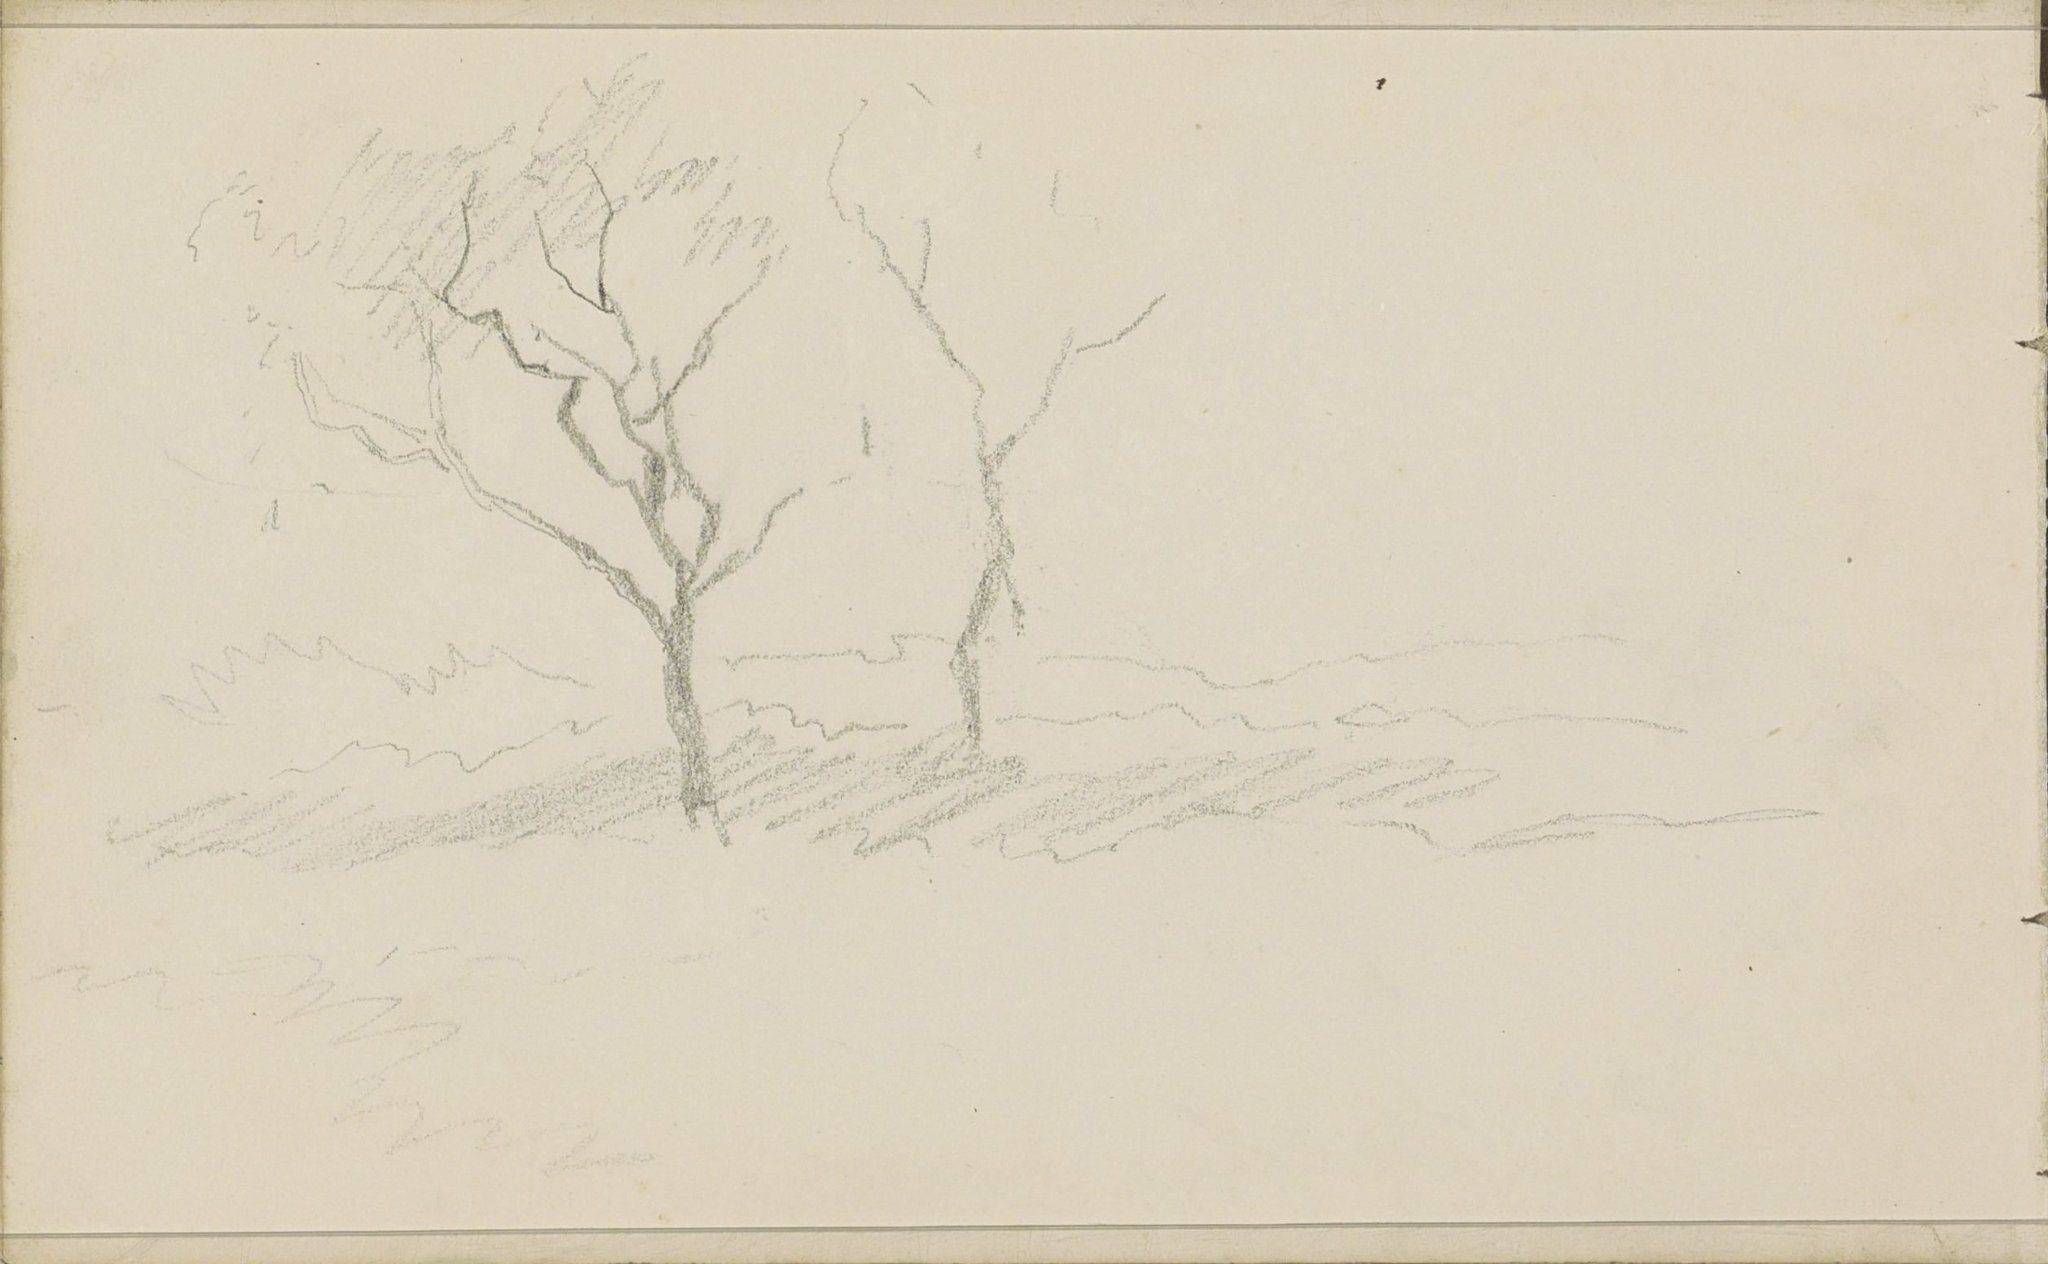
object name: sketchbook leaf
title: Ruiters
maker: anton mauve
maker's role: draughtsman, painter, print maker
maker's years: 1838-1888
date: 1848-1888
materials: paper, pencil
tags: trees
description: Blad 21 verso uit een schetsboek met 42 bladen.